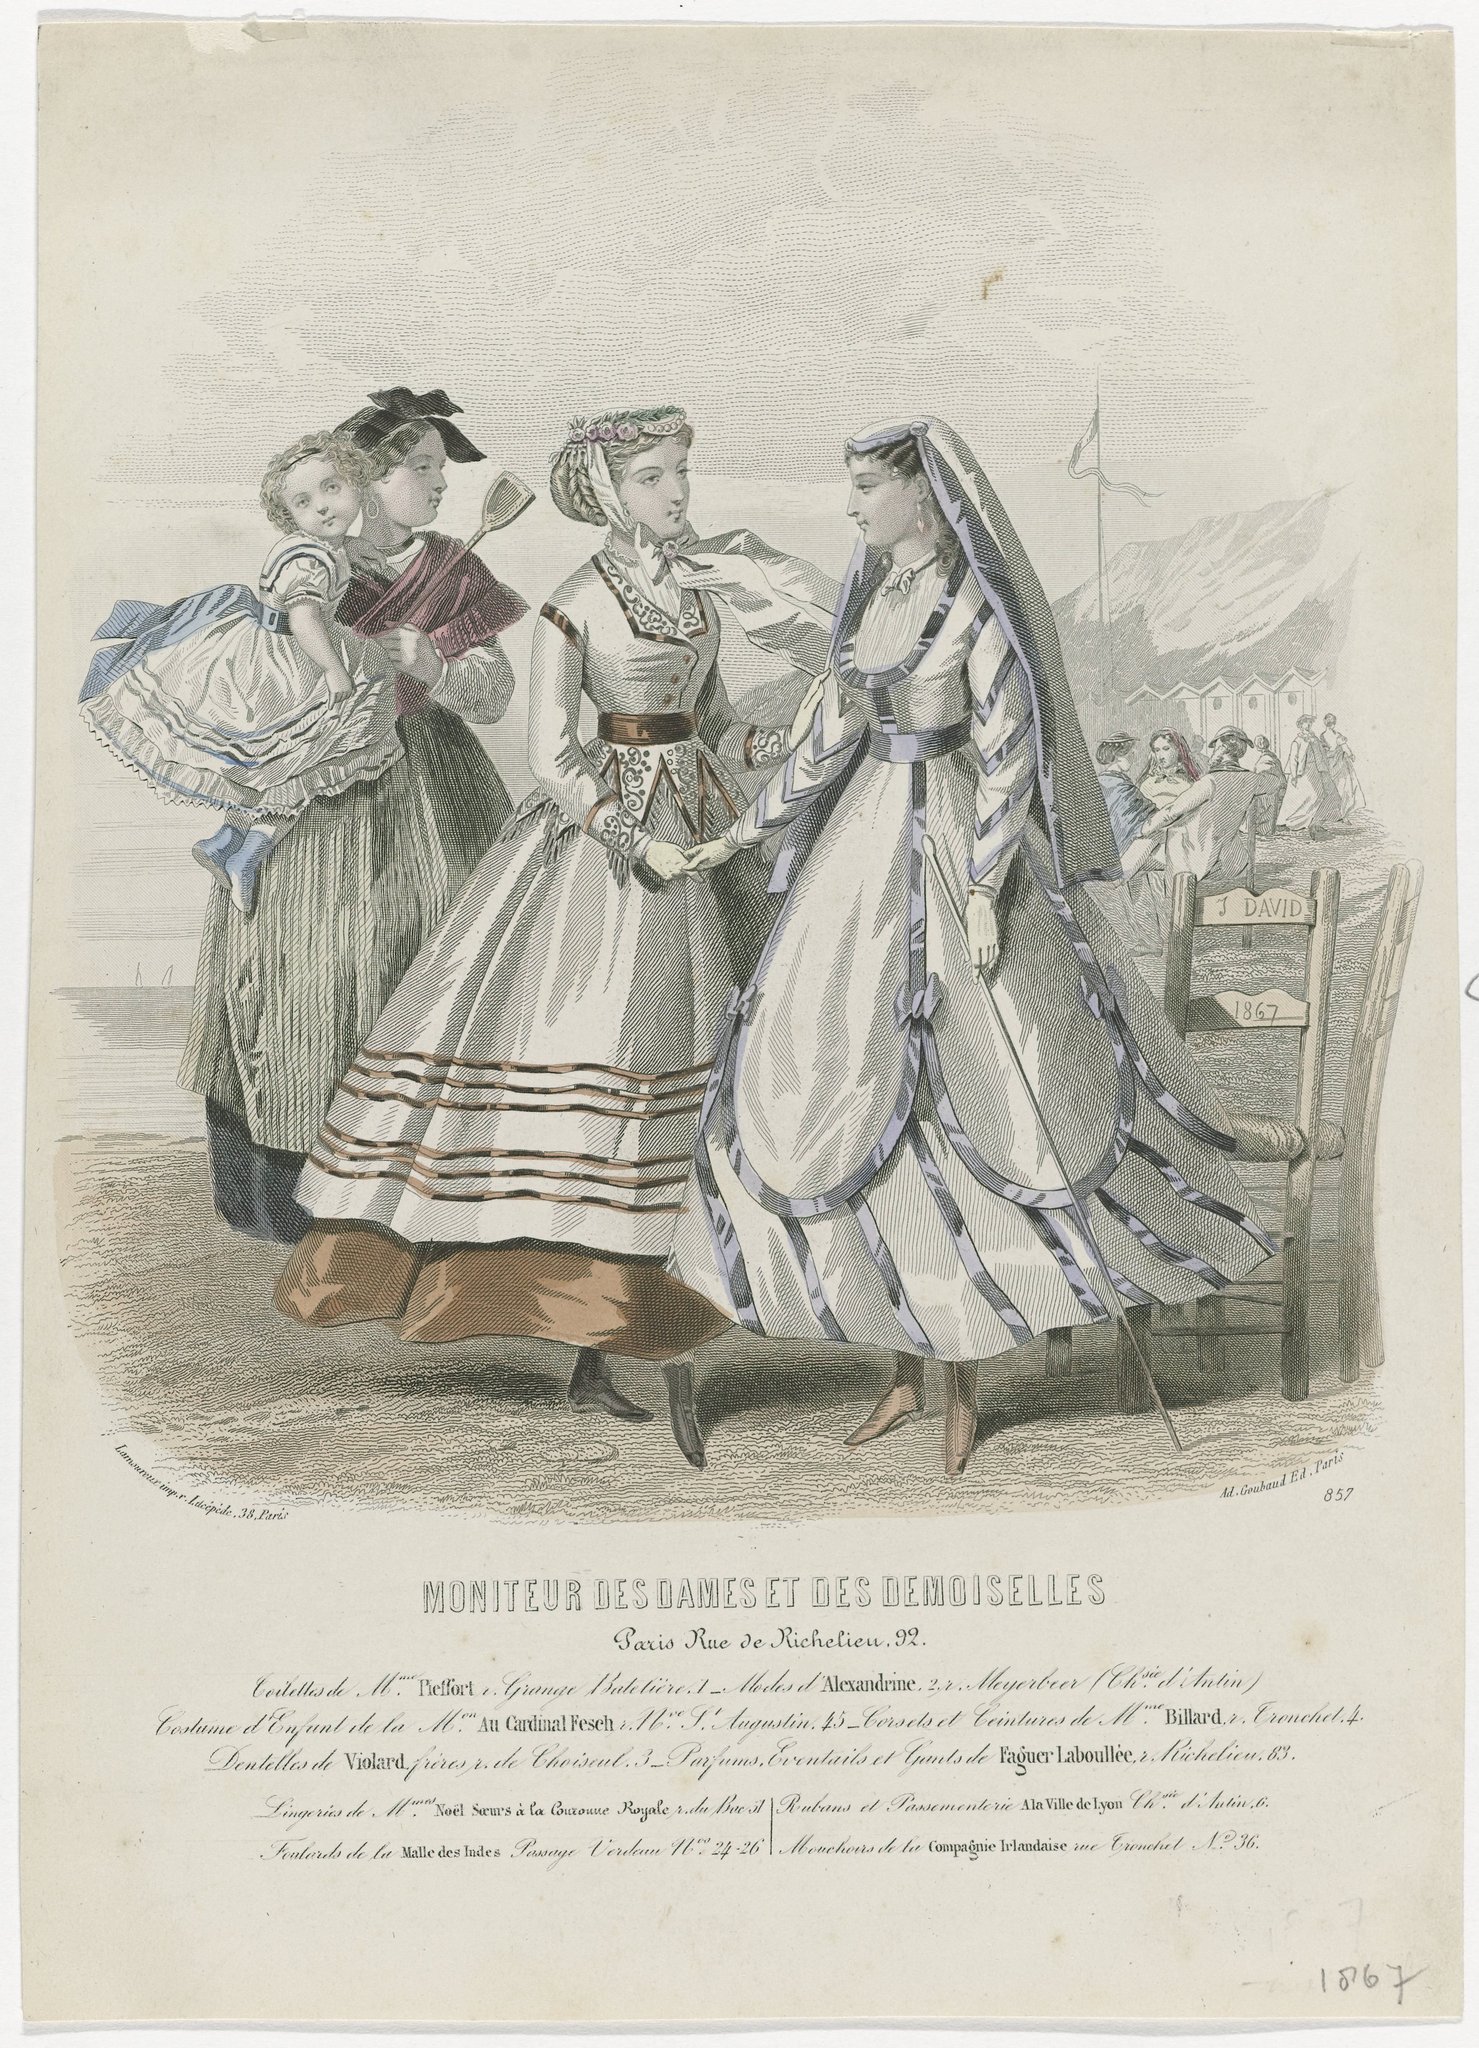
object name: fashion print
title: Moniteur des Dames et des Demoiselles, 1867, No. 857 : Toilettes de Mme Pieffort (...)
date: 1867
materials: paper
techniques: engraving, hand coloring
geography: paris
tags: recreation in the dunes, walking-stick, staff, cane (+ women's clothes), boots (+ women's clothes), boots (+ girls' clothes), head-gear (+ women's clothes), fashion plates, dress, gown (+ girls' clothes)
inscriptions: address: ‘Paris Rue de Richelieu, 92.’, caption: ‘Toilettes de Mme Pieffort r. Grange Batelière, 1 _ Modes d'Alexandrine, 2. r. Meyerbeer (Ch.sée d'Antin) Costume d'Enfant de la M.on Au Cardinal Fesch r. N.ve S.t Augustin. 45 _ Corsets et Ceintures de M.me Billard. r. Tronchet. 4. Dentelles de Violard. fr1eres r. de Choiseul. 3 _ Parfums, Eventails et Gants de Faguer Laboullée, r. Richelieu, 83. / Lingeries de M.mes Noël Soeurs à la Couronne Royale r. du Bac 51 / Foulards de la Malle des Indes Passage verdeau N.os 24-26 / Rubans et Passementerie A la Ville de Lyon Ch.sée d' Antin . 6 / Mouchoirs de la Compagnie Irlandaise rue Tronchet No. 36.’, title: ‘Le Moniteur des Dames et des Demoiselles’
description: Twee vrouwen in kostuums van Mme. Pieffort, staand op het strand.. Naast hen een kindermeisje met een meisje op de arm. Op de achtergrond enkele badgasten. Onder de afbeelding enkele regels reclametekst voor verschillende producten. Prent uit het modetijdschrift Moniteur des Dames et des Demoiselles (1854-1902).